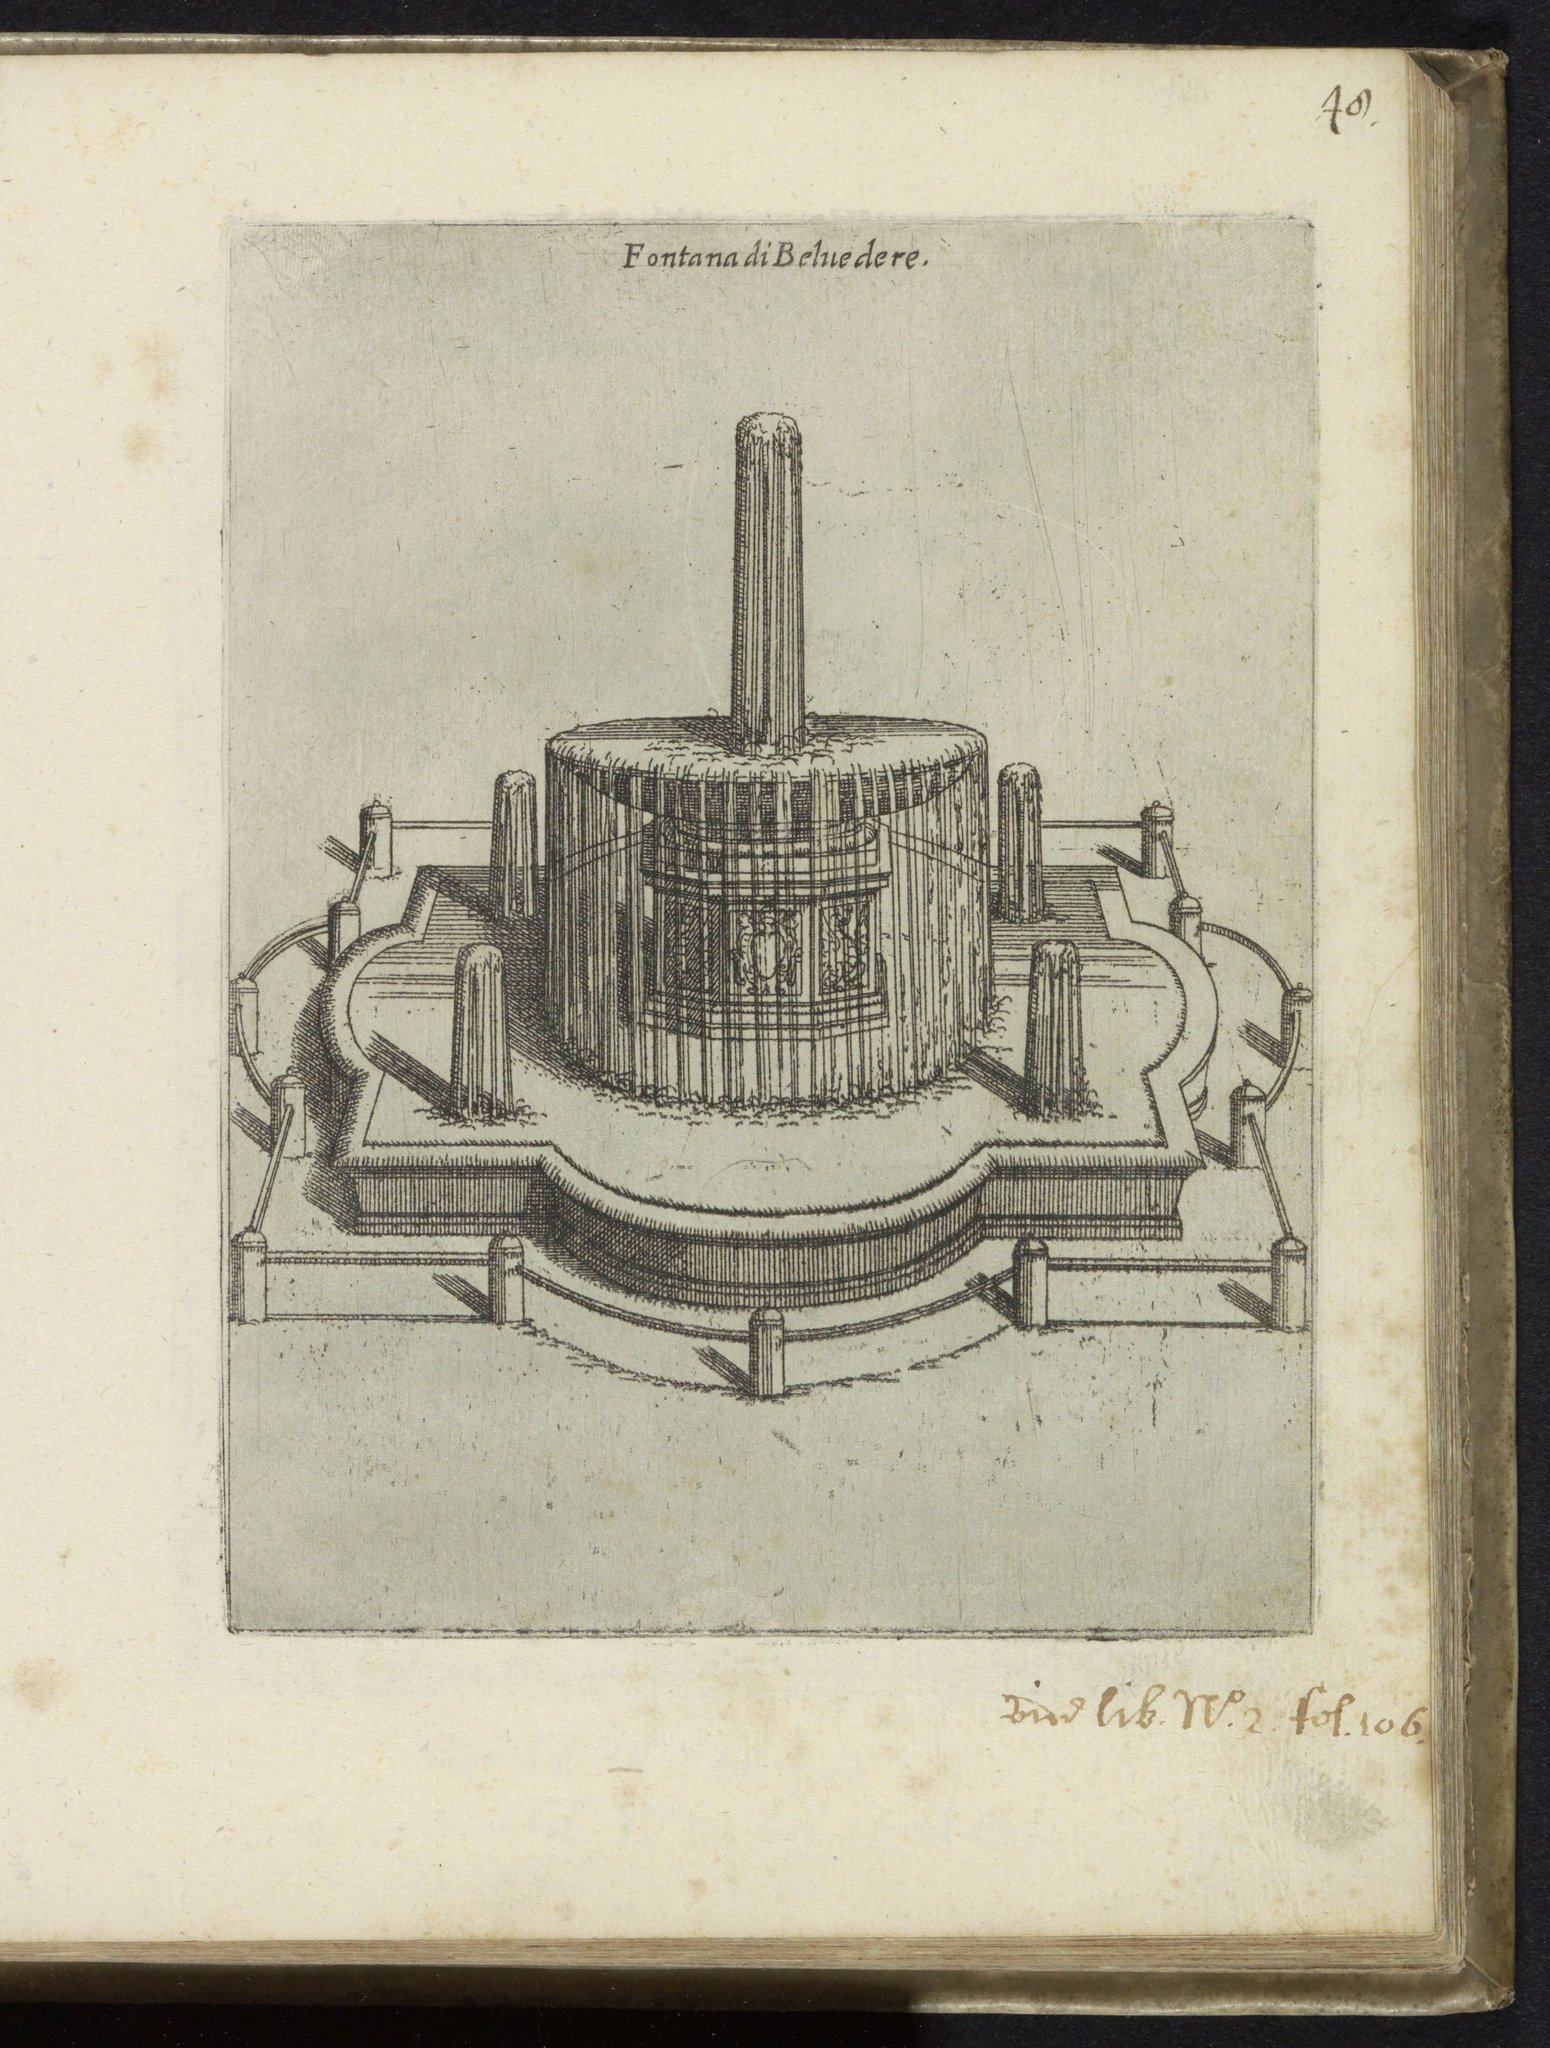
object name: album leaf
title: Fontana di Belvedere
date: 1637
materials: paper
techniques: etching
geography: rome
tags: ornamental fountain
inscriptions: inscription: ‘Ende lib. No. 8 fol. 85./ Ende lib. No. 21. fol. 22.’, inscription: ‘Ende lib. No. 2 fol. 106.’, number: ‘48’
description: Deze prent maakt deel uit van een reeks van ten minste 20 prenten (+ titelprent) van fonteinen in Rome.